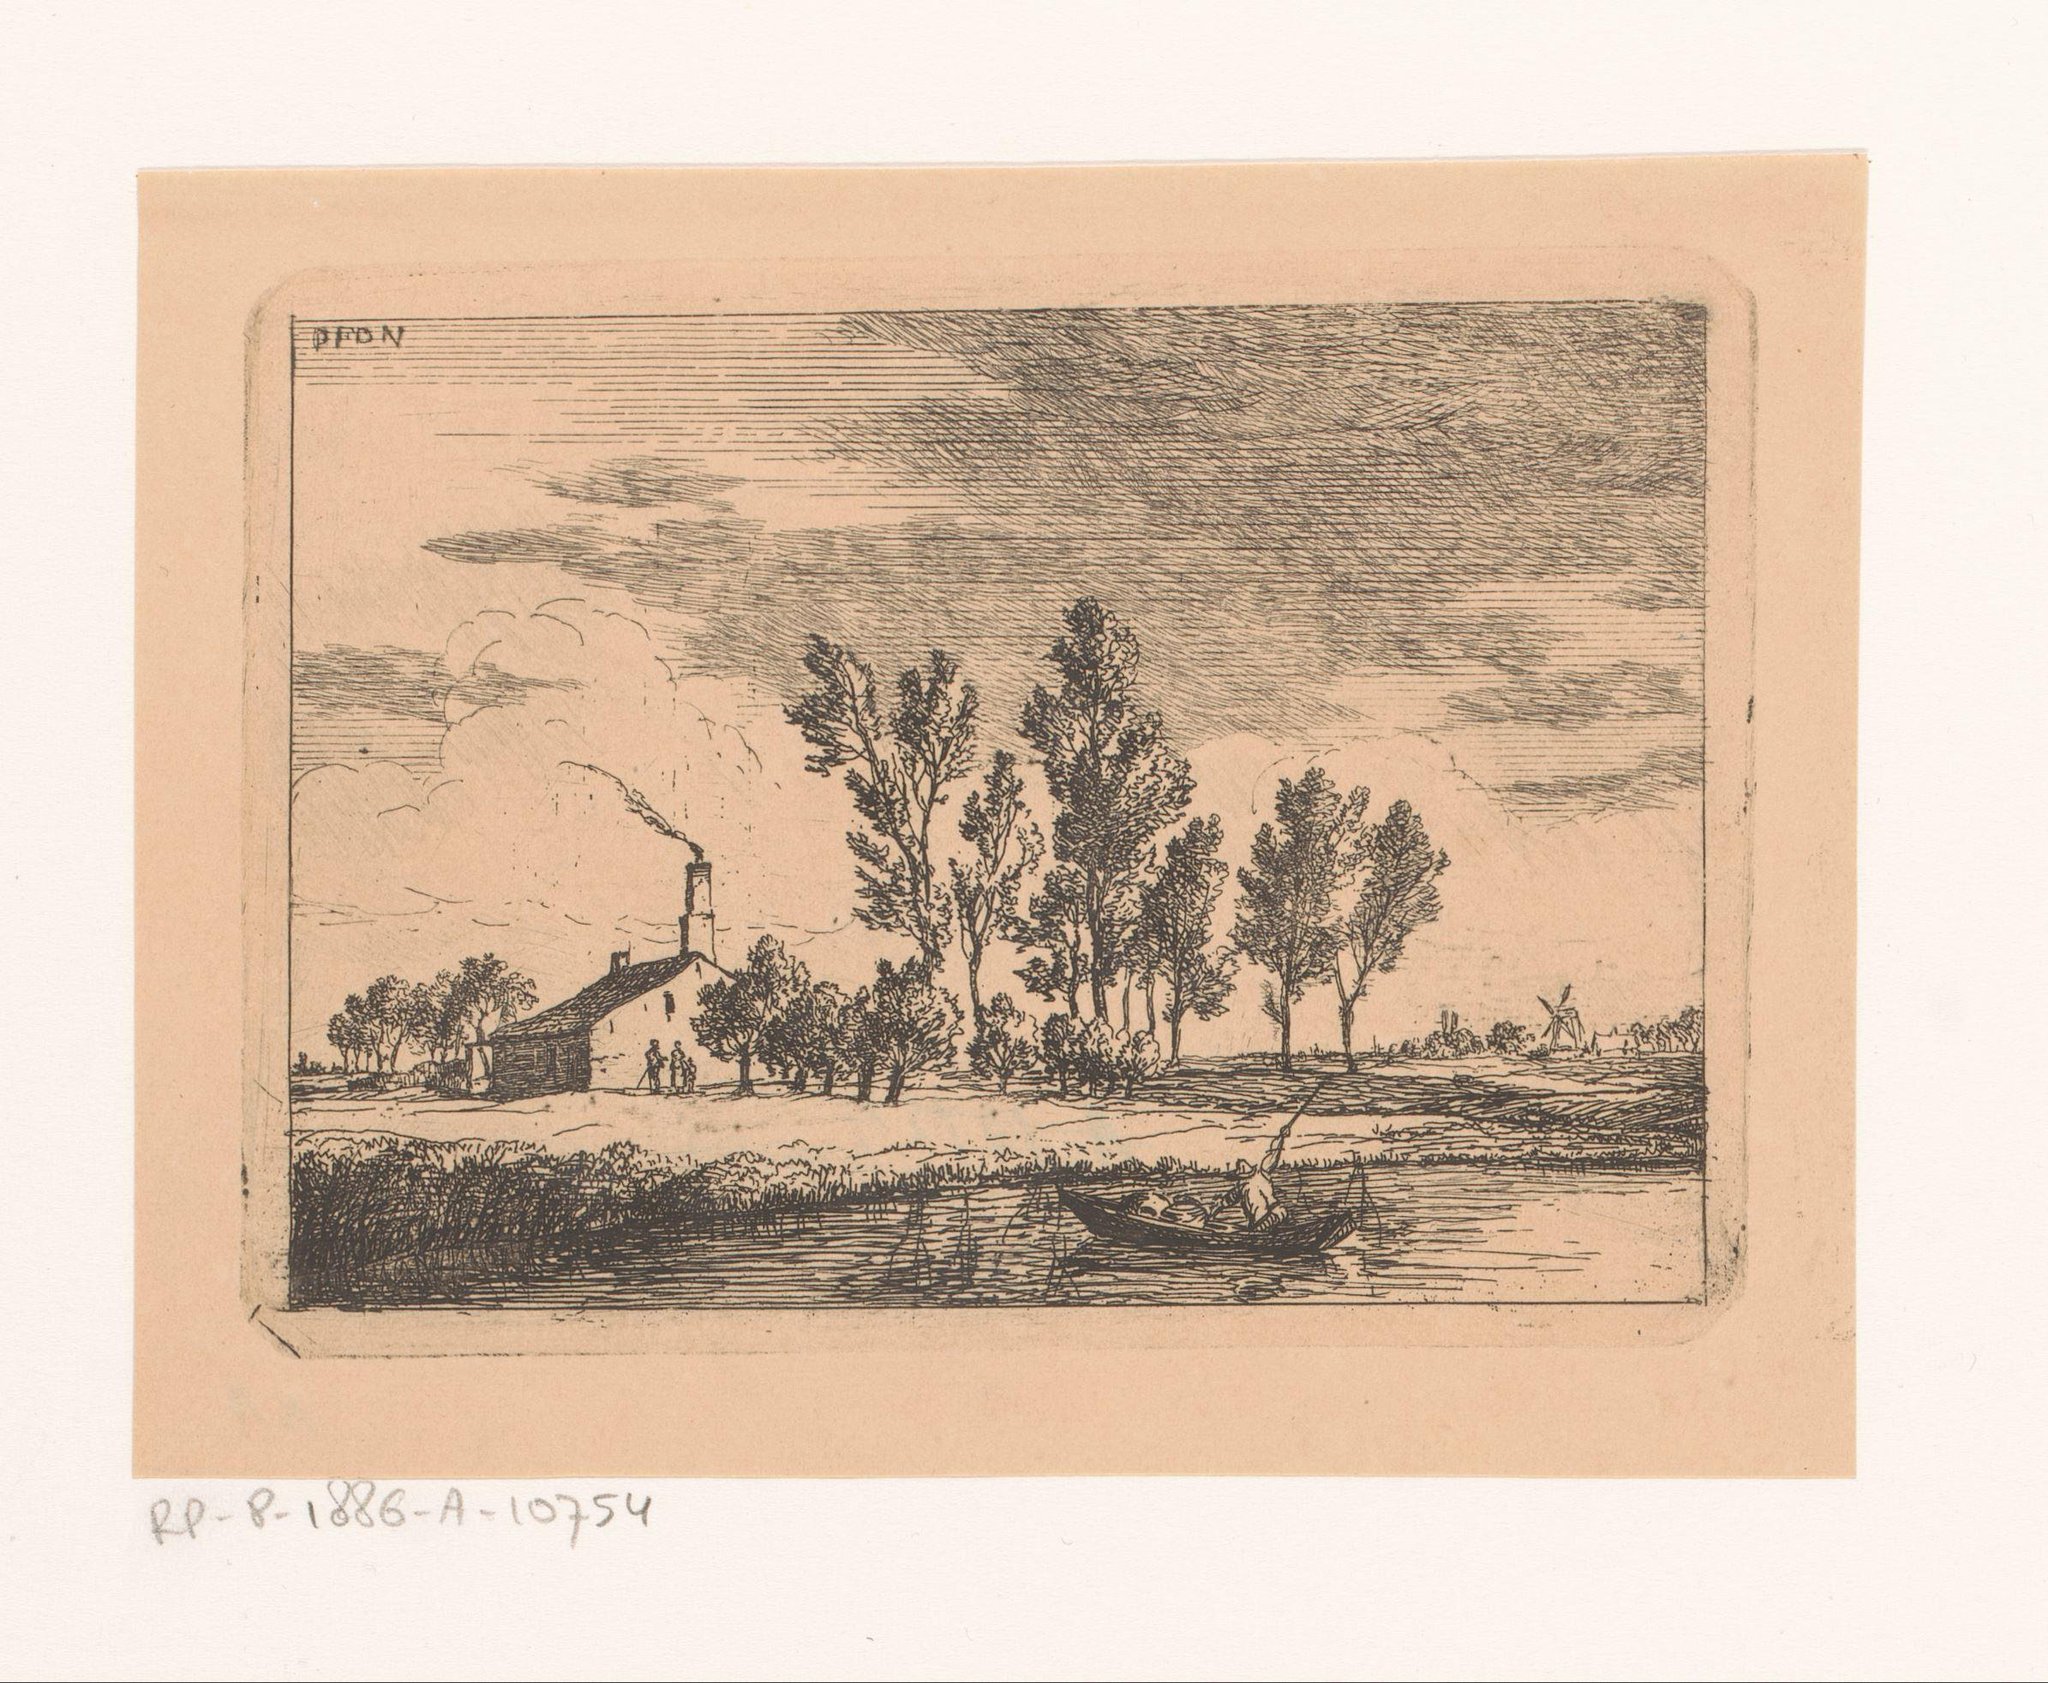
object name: print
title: Landschap met woning en vissersboot op het water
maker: pierre françois de noter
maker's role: painter, print maker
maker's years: 1779-1843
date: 1811-1831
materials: paper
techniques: etching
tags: farm or solitary house in landscape (+ city(-scape) with figures, staffage), angling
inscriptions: collector's mark: Lugt 2228